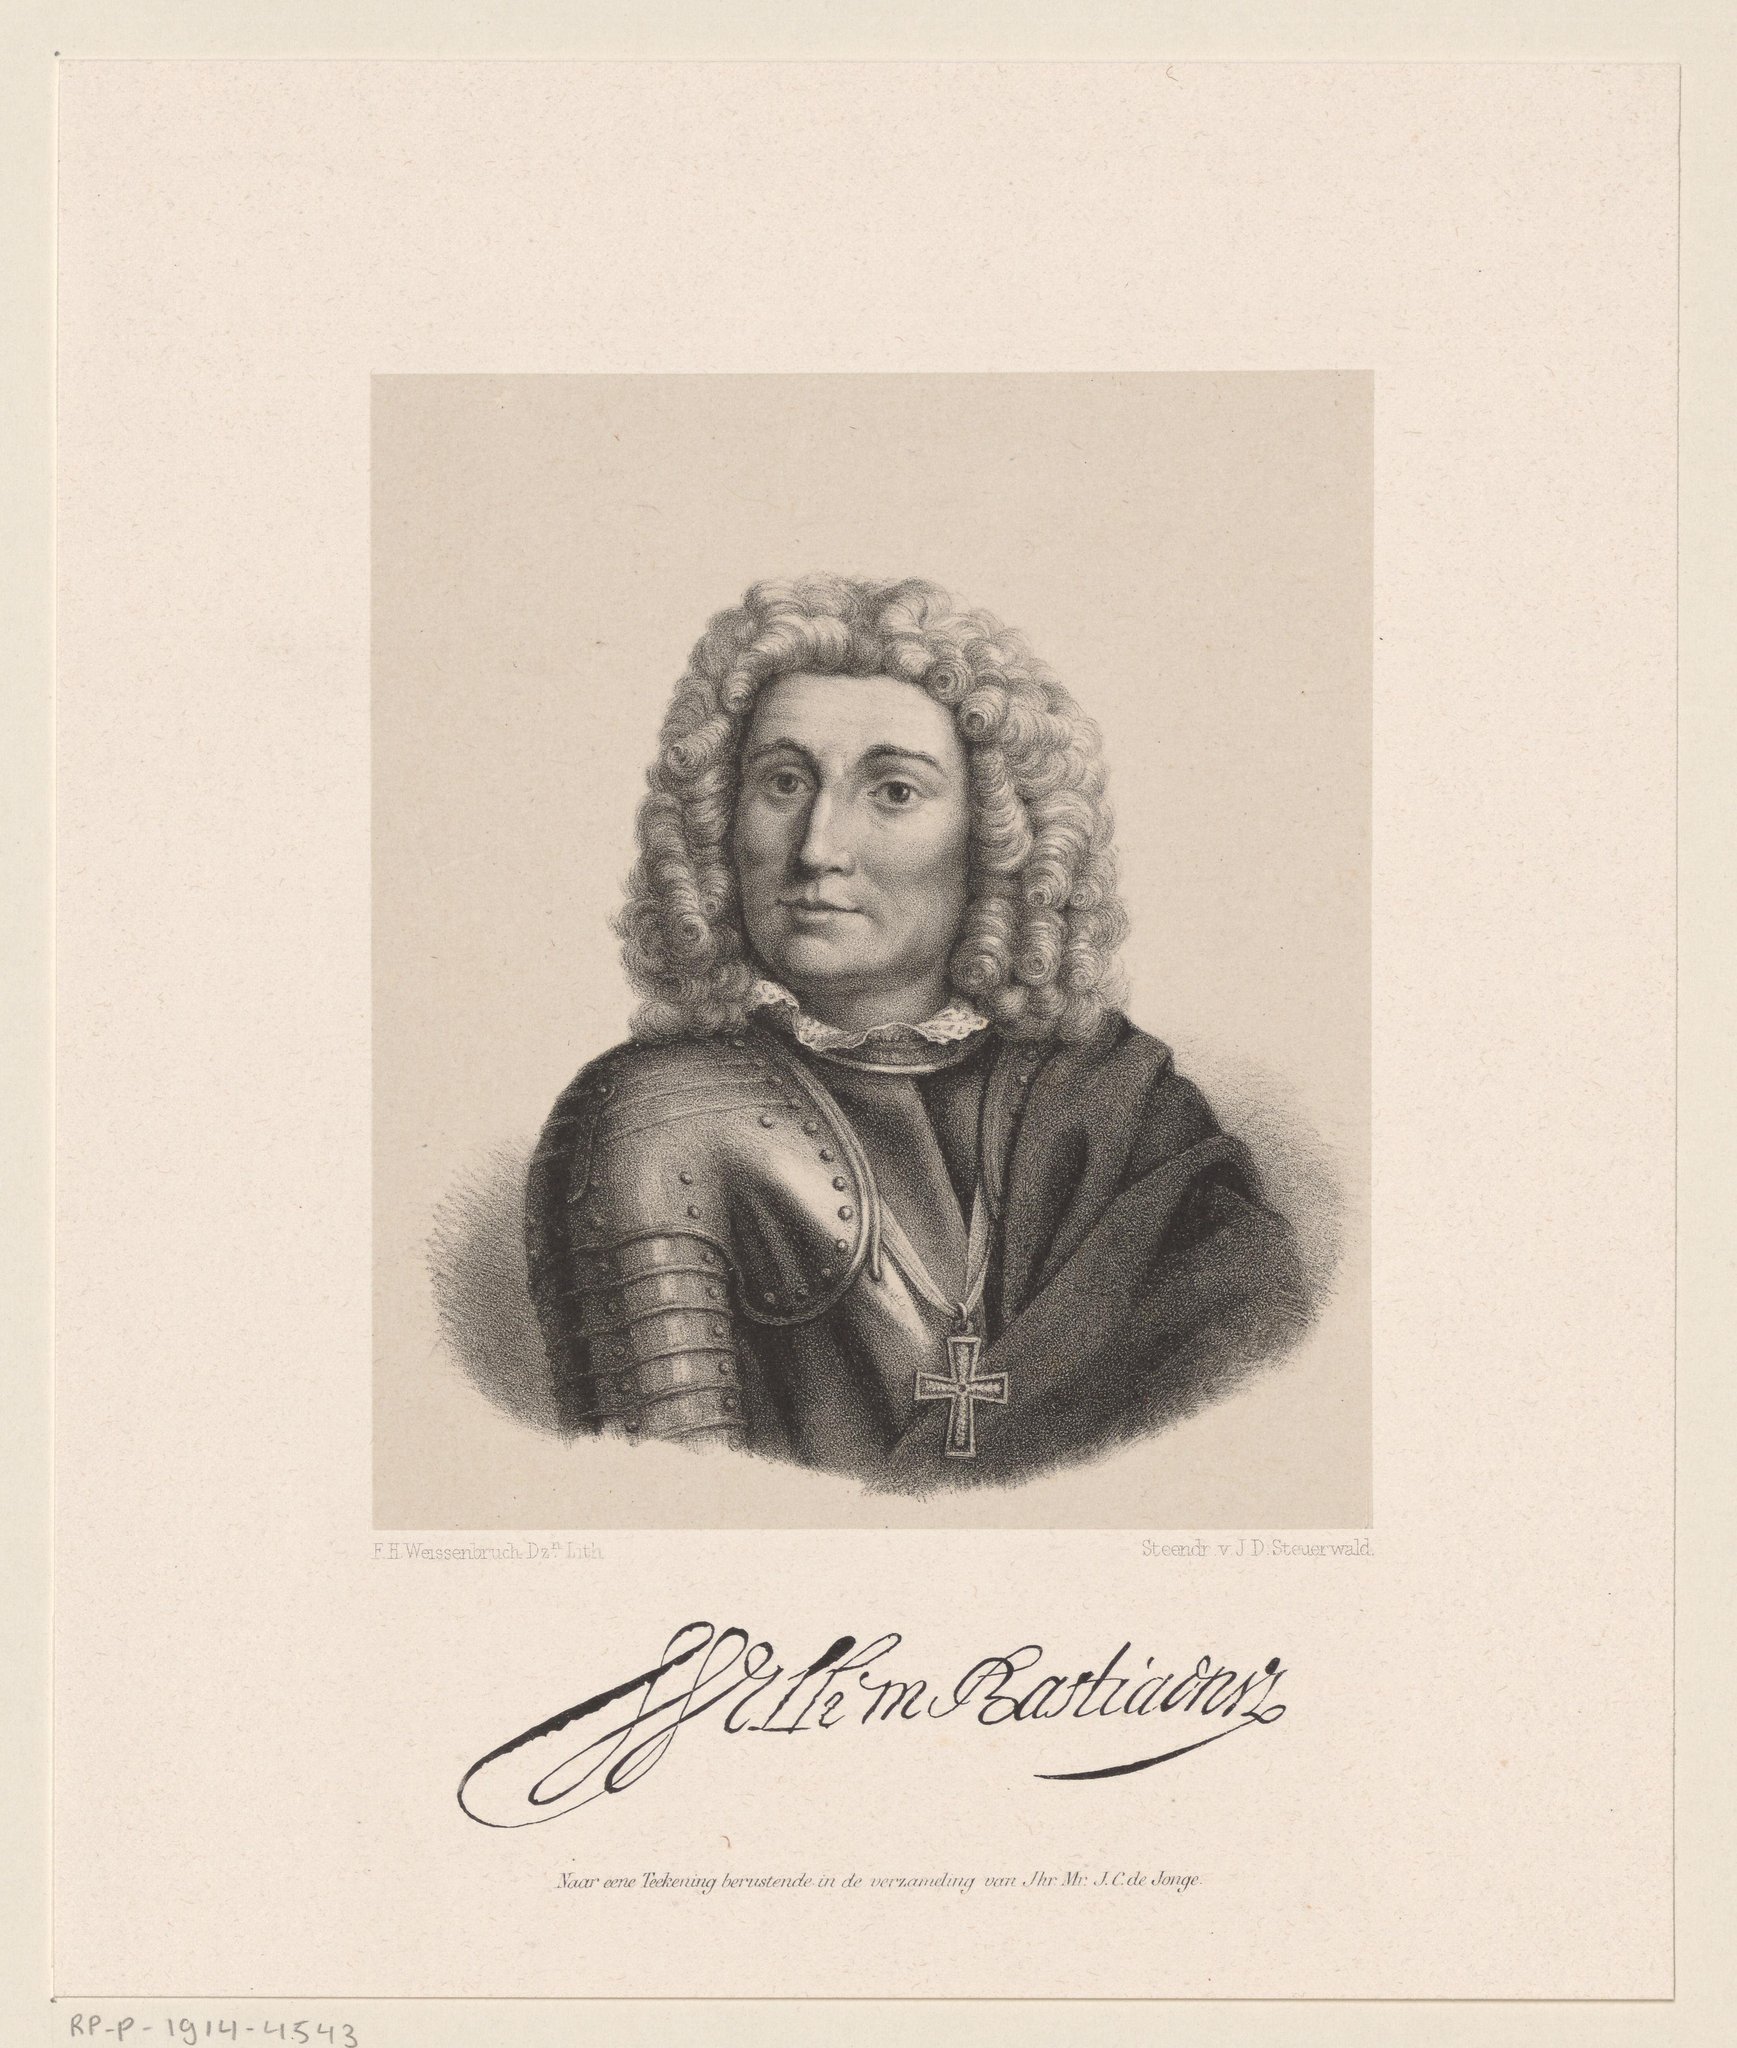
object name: print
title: Portret van Willem Bastiaansz Schepers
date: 1860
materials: paper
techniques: lithograph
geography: haarlem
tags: haarlem, rotterdam, mayor, armour, historical persons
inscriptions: collector's mark: Lugt 2228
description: Prent uit: Jonge, Johannes Cornelis de. Geschiedenis van het Nederlandsche zeewezen. Haarlem: Arie Cornelis Kruseman, 1860, dl. 3.